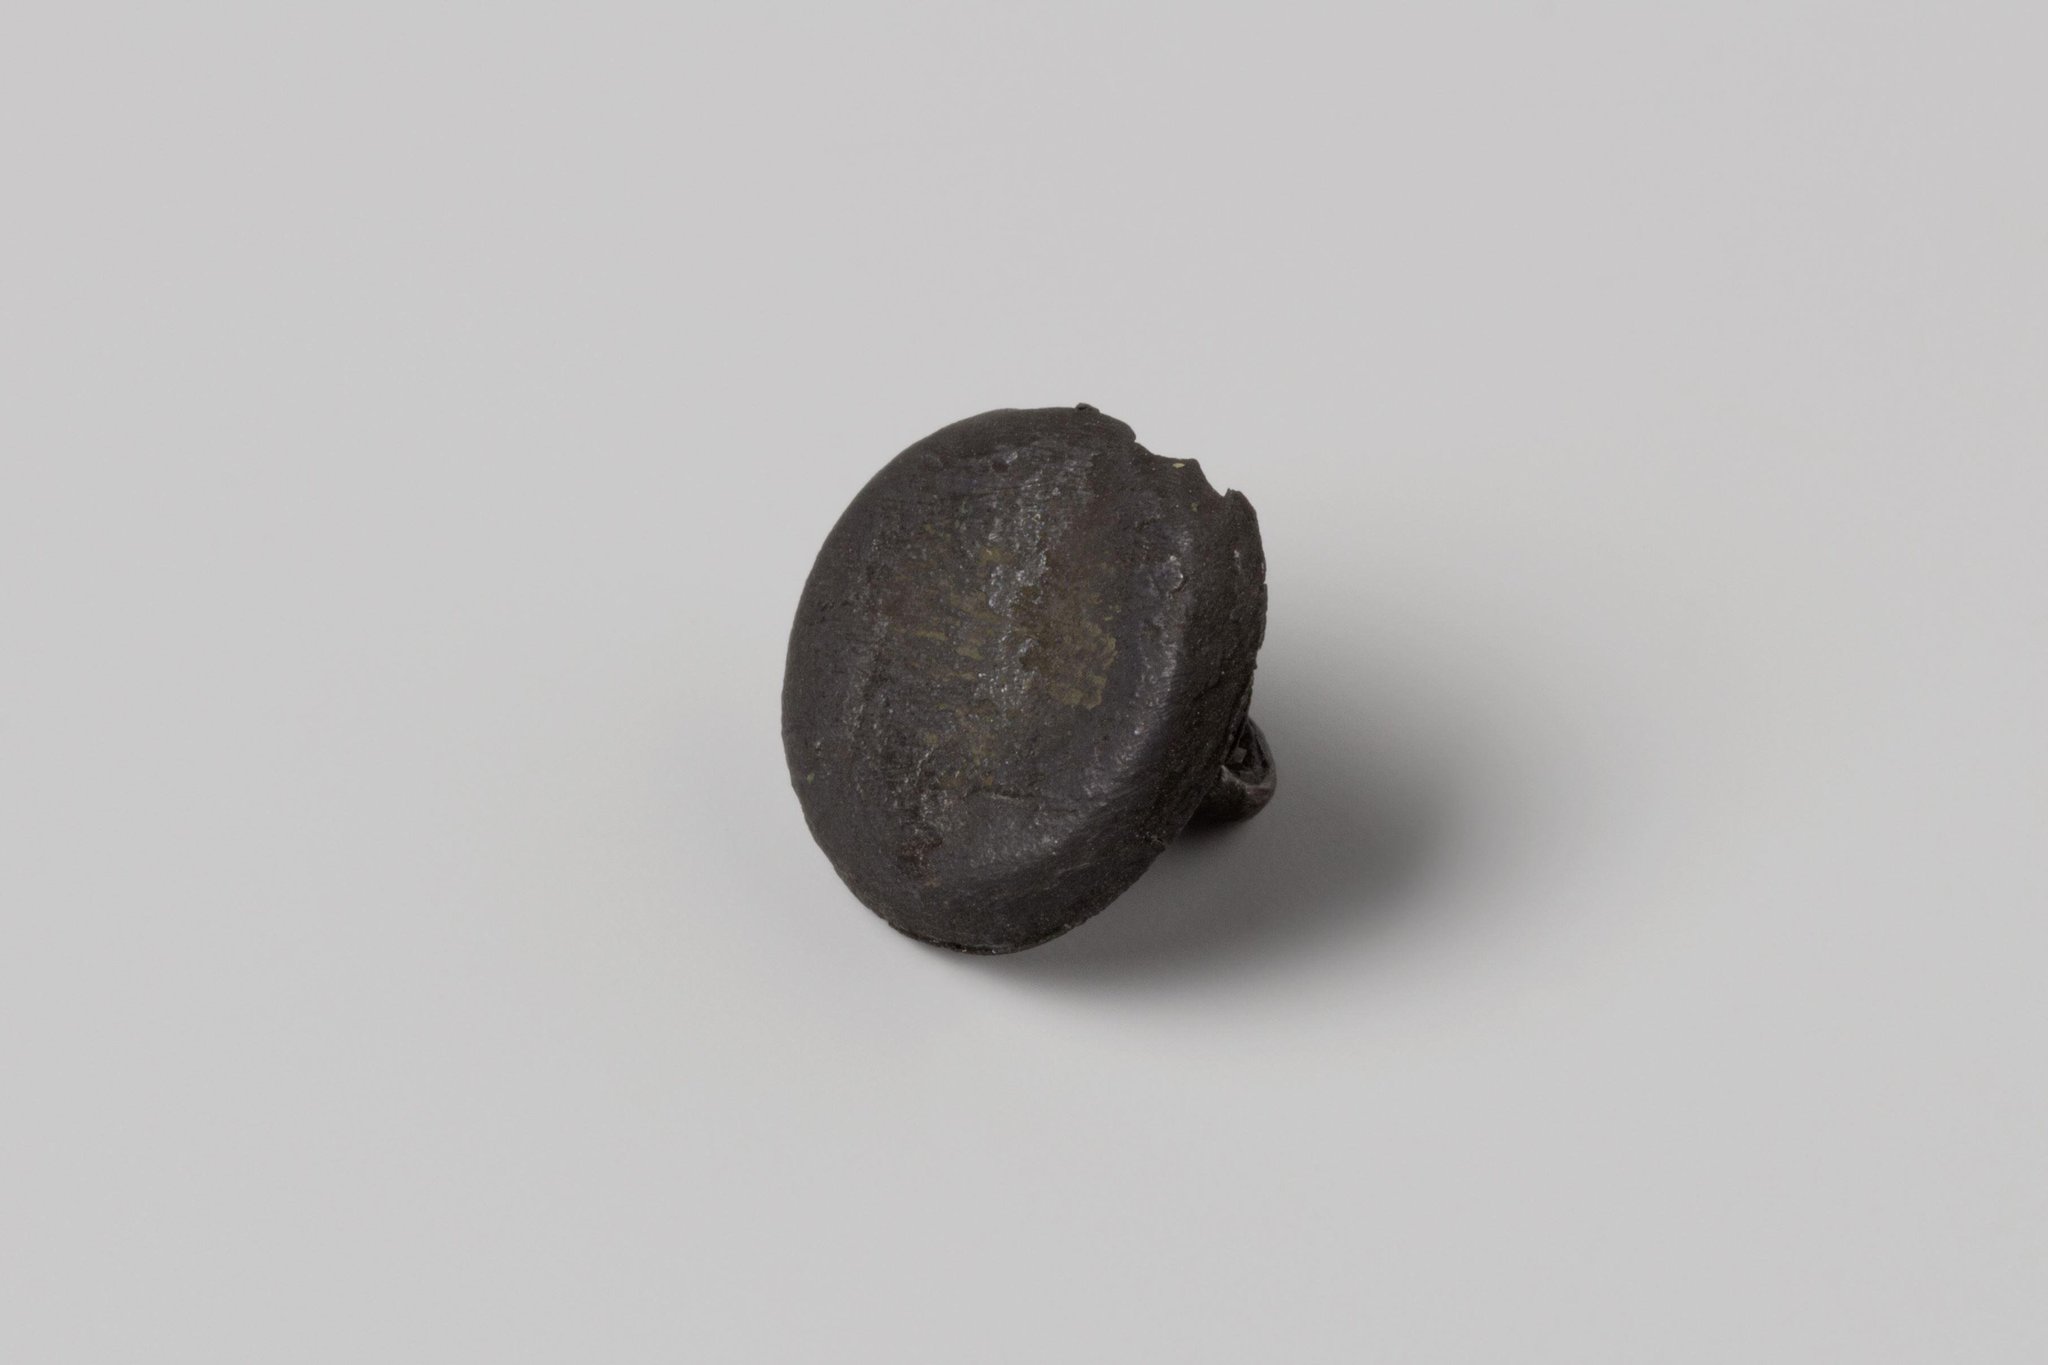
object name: button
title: Knoop uit het wrak van de Oost-Indiëvaarder Hollandia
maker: Anonymous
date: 1700-1743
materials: silver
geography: netherlands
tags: verenigde oostindische compagnie, hollandia (schip), annet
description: Knoop. Button; (1) slightly conical base, loop-shank, separate top, flat, bevelled rim, hollow (1.5d).